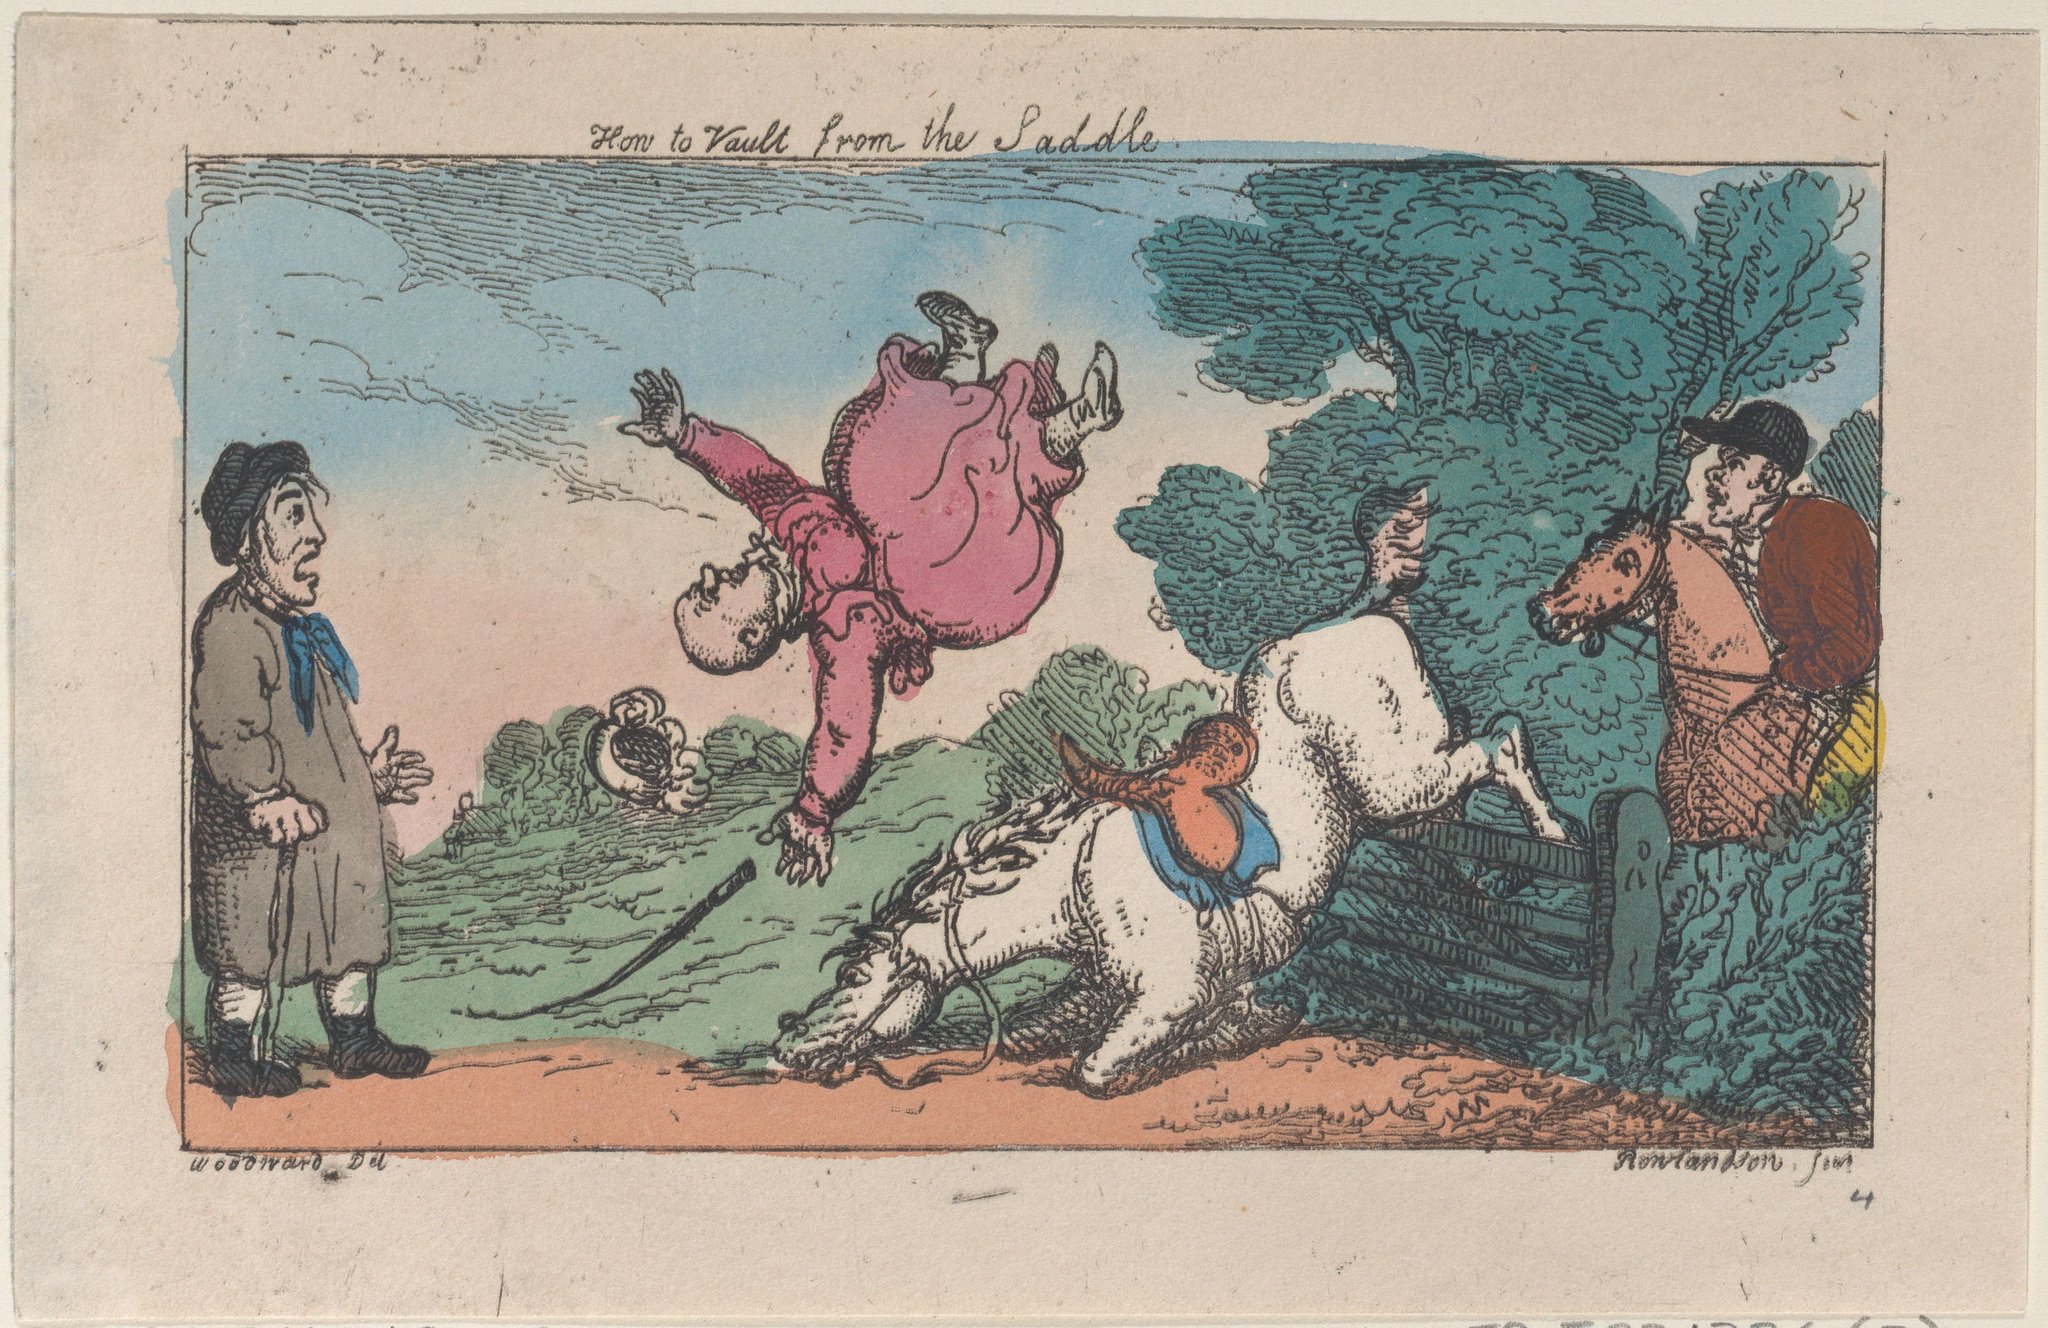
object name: print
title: How to Vault from the Saddle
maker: thomas rowlandson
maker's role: artist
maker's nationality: british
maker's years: 1757-1827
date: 1809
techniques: etching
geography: london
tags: satire,men,women,horses